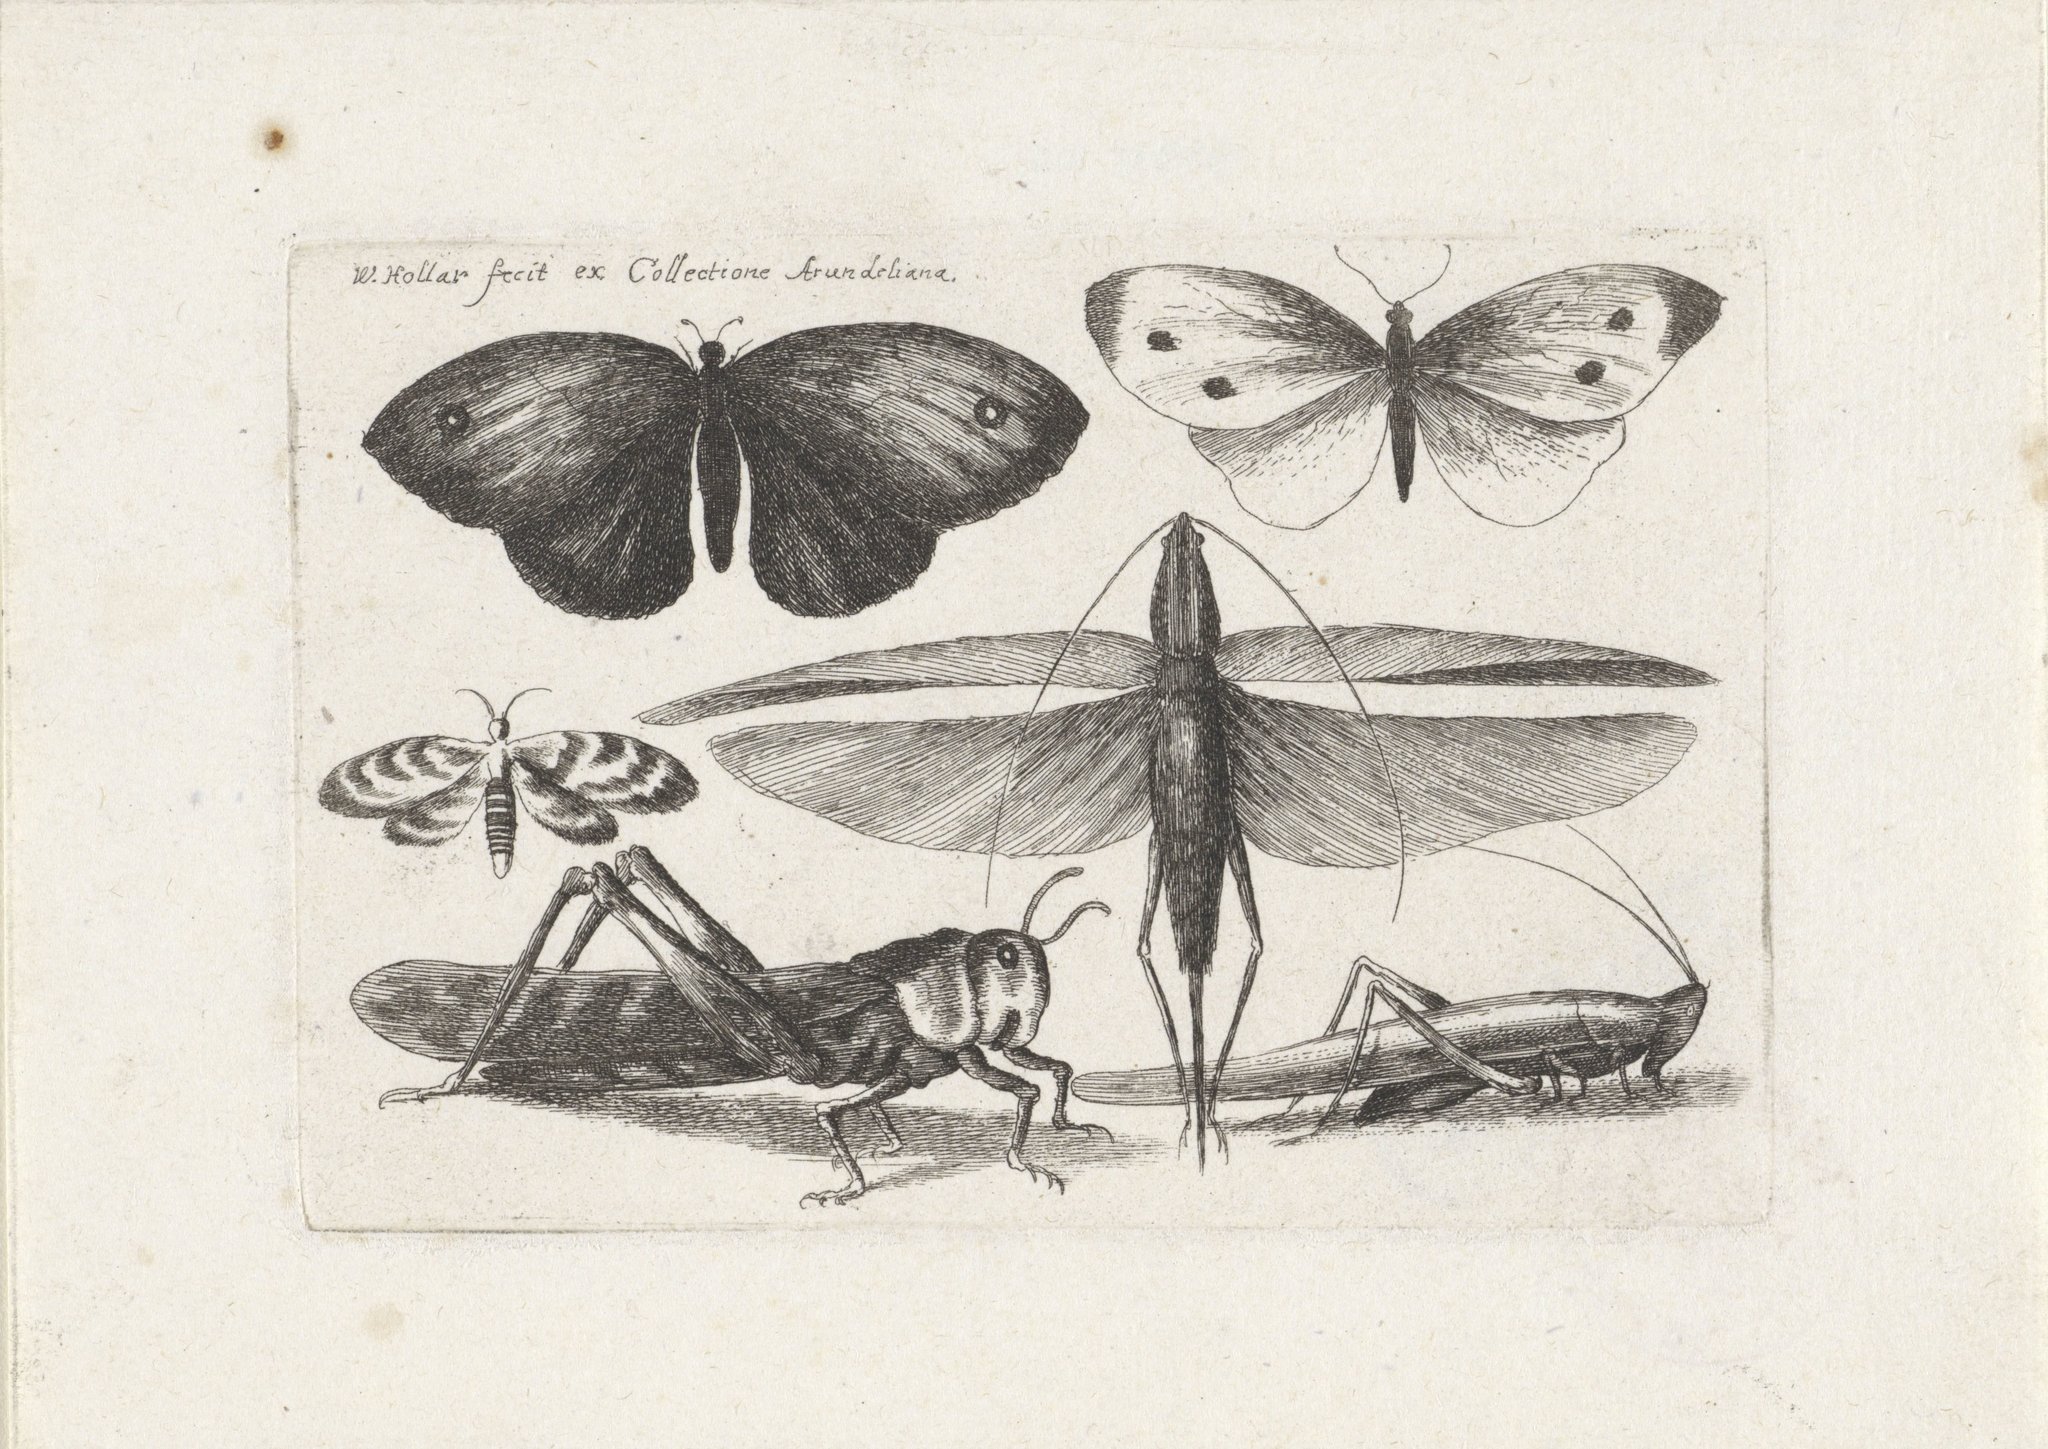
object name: print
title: Sprinkhanen en vlinders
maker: wenceslaus hollar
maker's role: draughtsman, print maker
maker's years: 1607-1677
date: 1646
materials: paper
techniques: etching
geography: antwerp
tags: insects: butterfly, insects: grass-hopper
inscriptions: collector's mark: Lugt 240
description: Prent maakt deel uit van de twaalfdelige serie (incl. titelprent) met verschillende insecten: "Muscarum Scarabeorum".